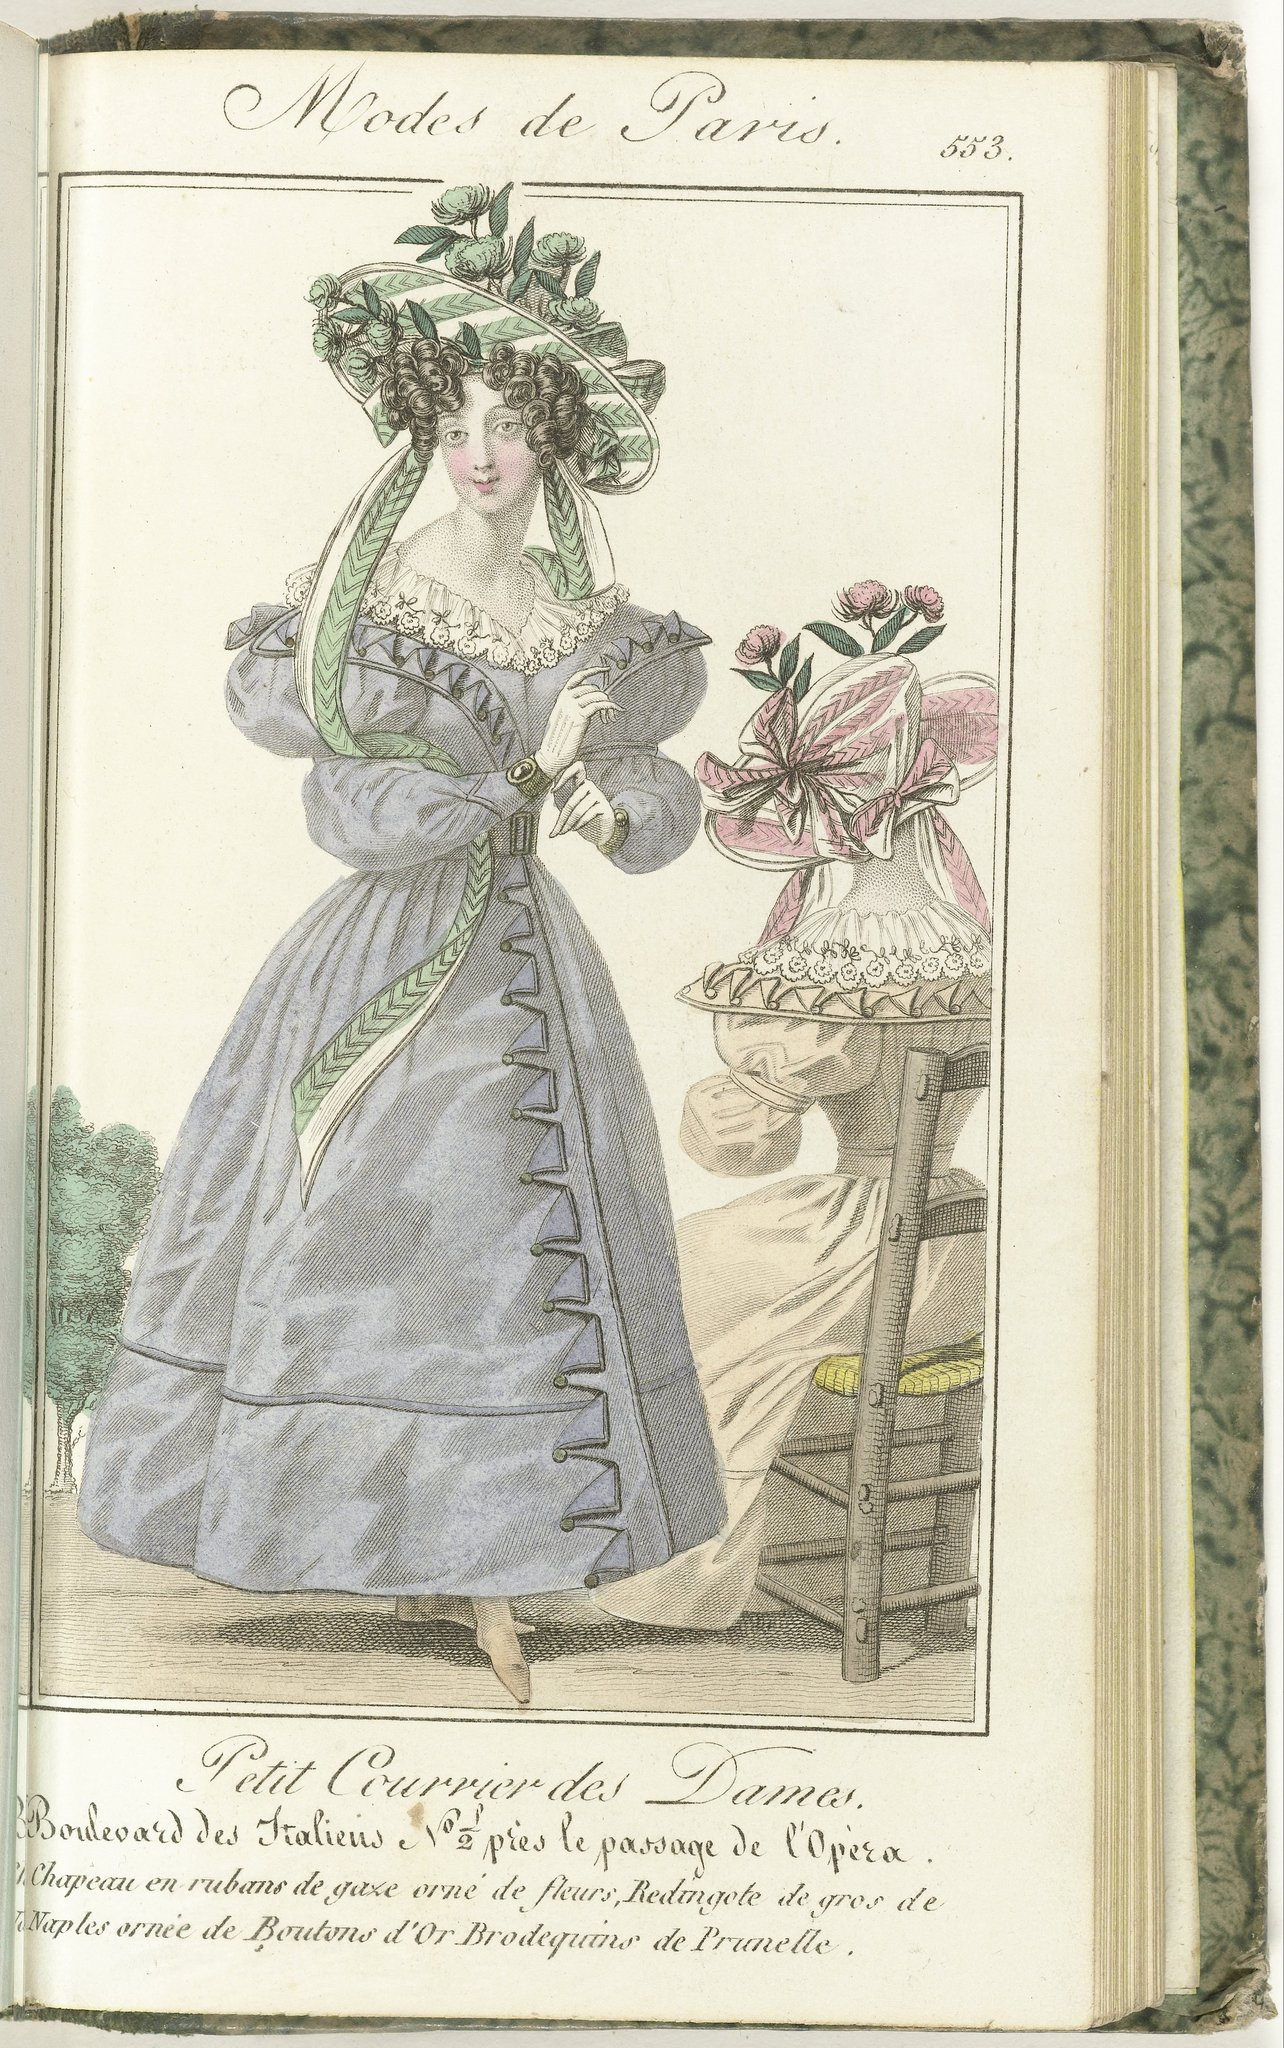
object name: fashion print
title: Petit Courrier des Dames, 10 mai 1828, No. 553 : Chapeau en rubans de gaze...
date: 1828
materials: paper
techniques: engraving, hand coloring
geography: paris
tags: button (+ women's clothes), border, ribbon, braid (+ women's clothes), dress, gown: redingote (+ women's clothes), fashion plates, head-gear: hat (+ women's clothes), bracelet, wristlet (+ women's clothes)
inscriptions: address: ‘Boulevard des Italiens No.2 près le passage de l'Opèra.’, title: ‘Petit Courrier des Dames.’, caption: ‘Chapeau en rubans de gaze orné de fleurs, Redingote de gros de Naples ornée de Boutons d'Or Brodequins de Prunelle’, title: ‘Modes de Paris.’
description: Staande vrouw gekleed in een redingote van 'gros de Naples' versierd met goudkleurige knopen. Op het hoofd een hoed van linten van gaas versierd met bloemen. Laarzen van 'Prunelle'. Zittende figuur in eenzelfde japon, op de rug gezien. Prent uit het modetijdschrift Petit Courrier des Dames (1821-1868). Ingebonden (met enkele pp. Le Journal des Dames et des Modes). 15 Januari 1827 t/m 20 maart 1830. Incompleet.